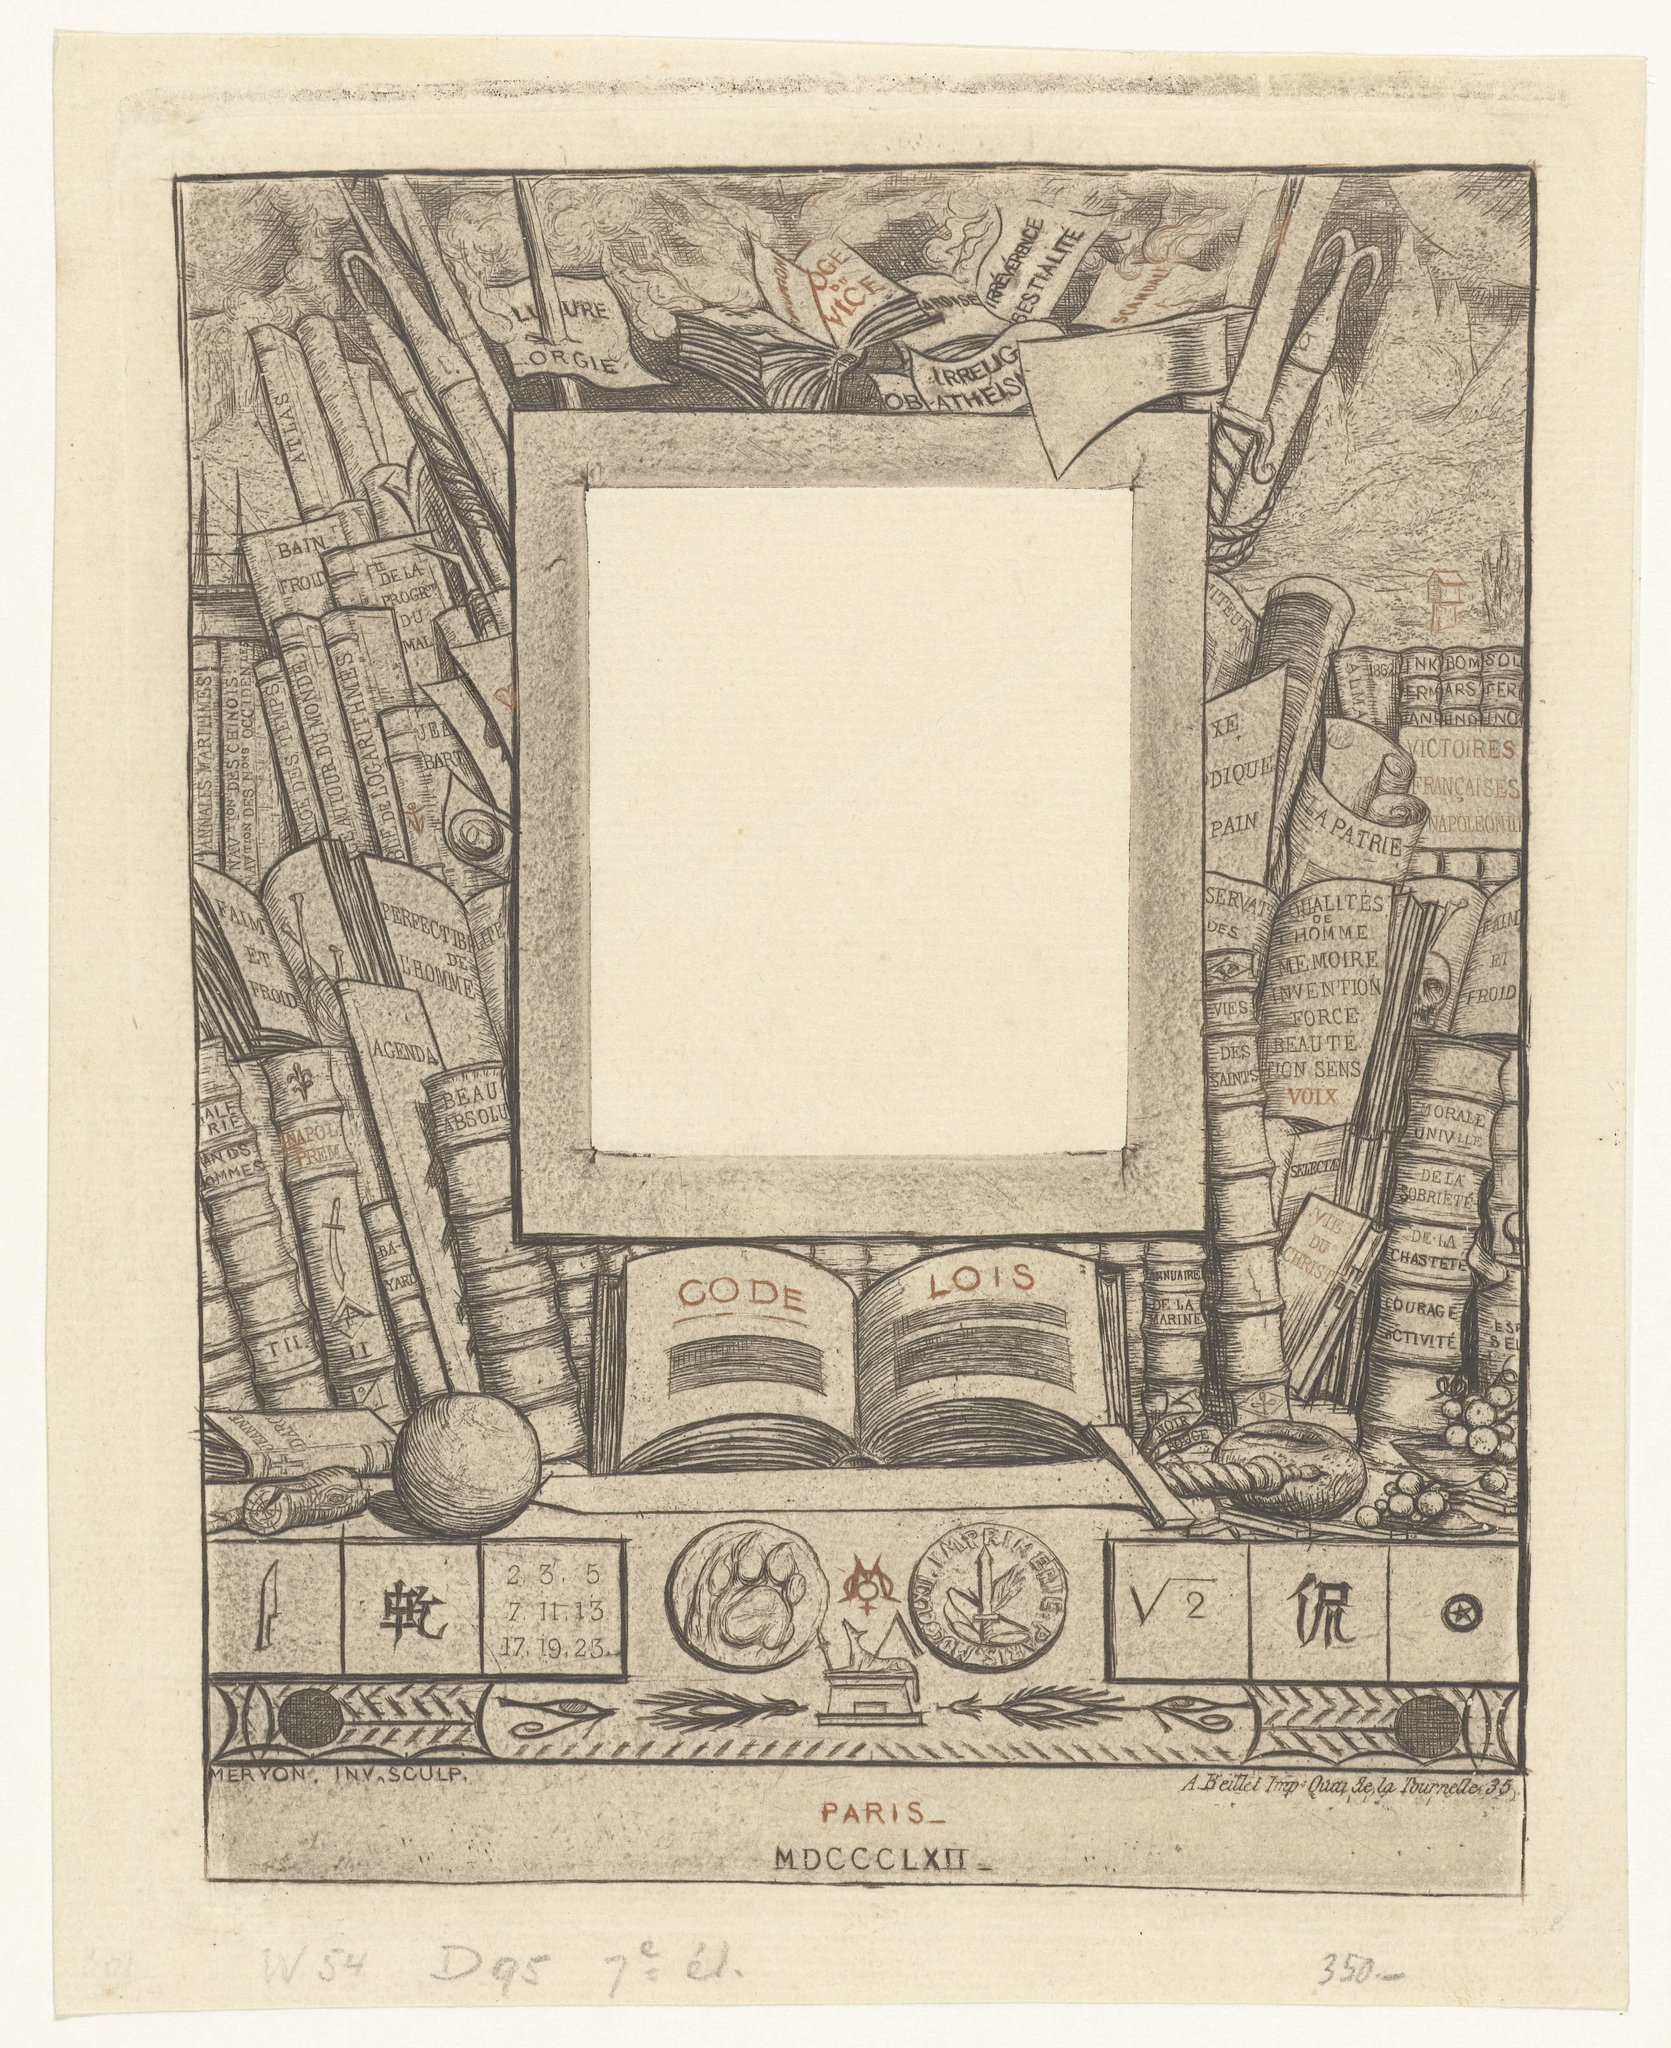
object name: print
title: Omlijsting voor portret van Armand Guéraud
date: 1862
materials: paper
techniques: drypoint, etching, lithography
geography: paris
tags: book, tools, implements of printer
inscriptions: collector's mark:, collector's mark: Lugt 200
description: Omlijsting met allegorische voorstelling van de uitvinding en toepassing van de drukkunst. Boeken met titels op de banden en drukkersgereedschappen staan op elkaar gestapeld ronde een leeg kader. Onder het kader, bedoeld voor het portret van de drukker Armand Guéraud, ligt een wetboek met een zwaard. In een band onderaan staan onder andere Chinese karakters en hierogliefen. Meryon nam veel moeite voor de uitwerking van de omlijsting, hij vervaardigde veertien staten en wijzigde steeds de titels op de boeken naast nog andere details. Opvallend zijn enkele rode accenten waar de kunstnaar mee experimenteerde.